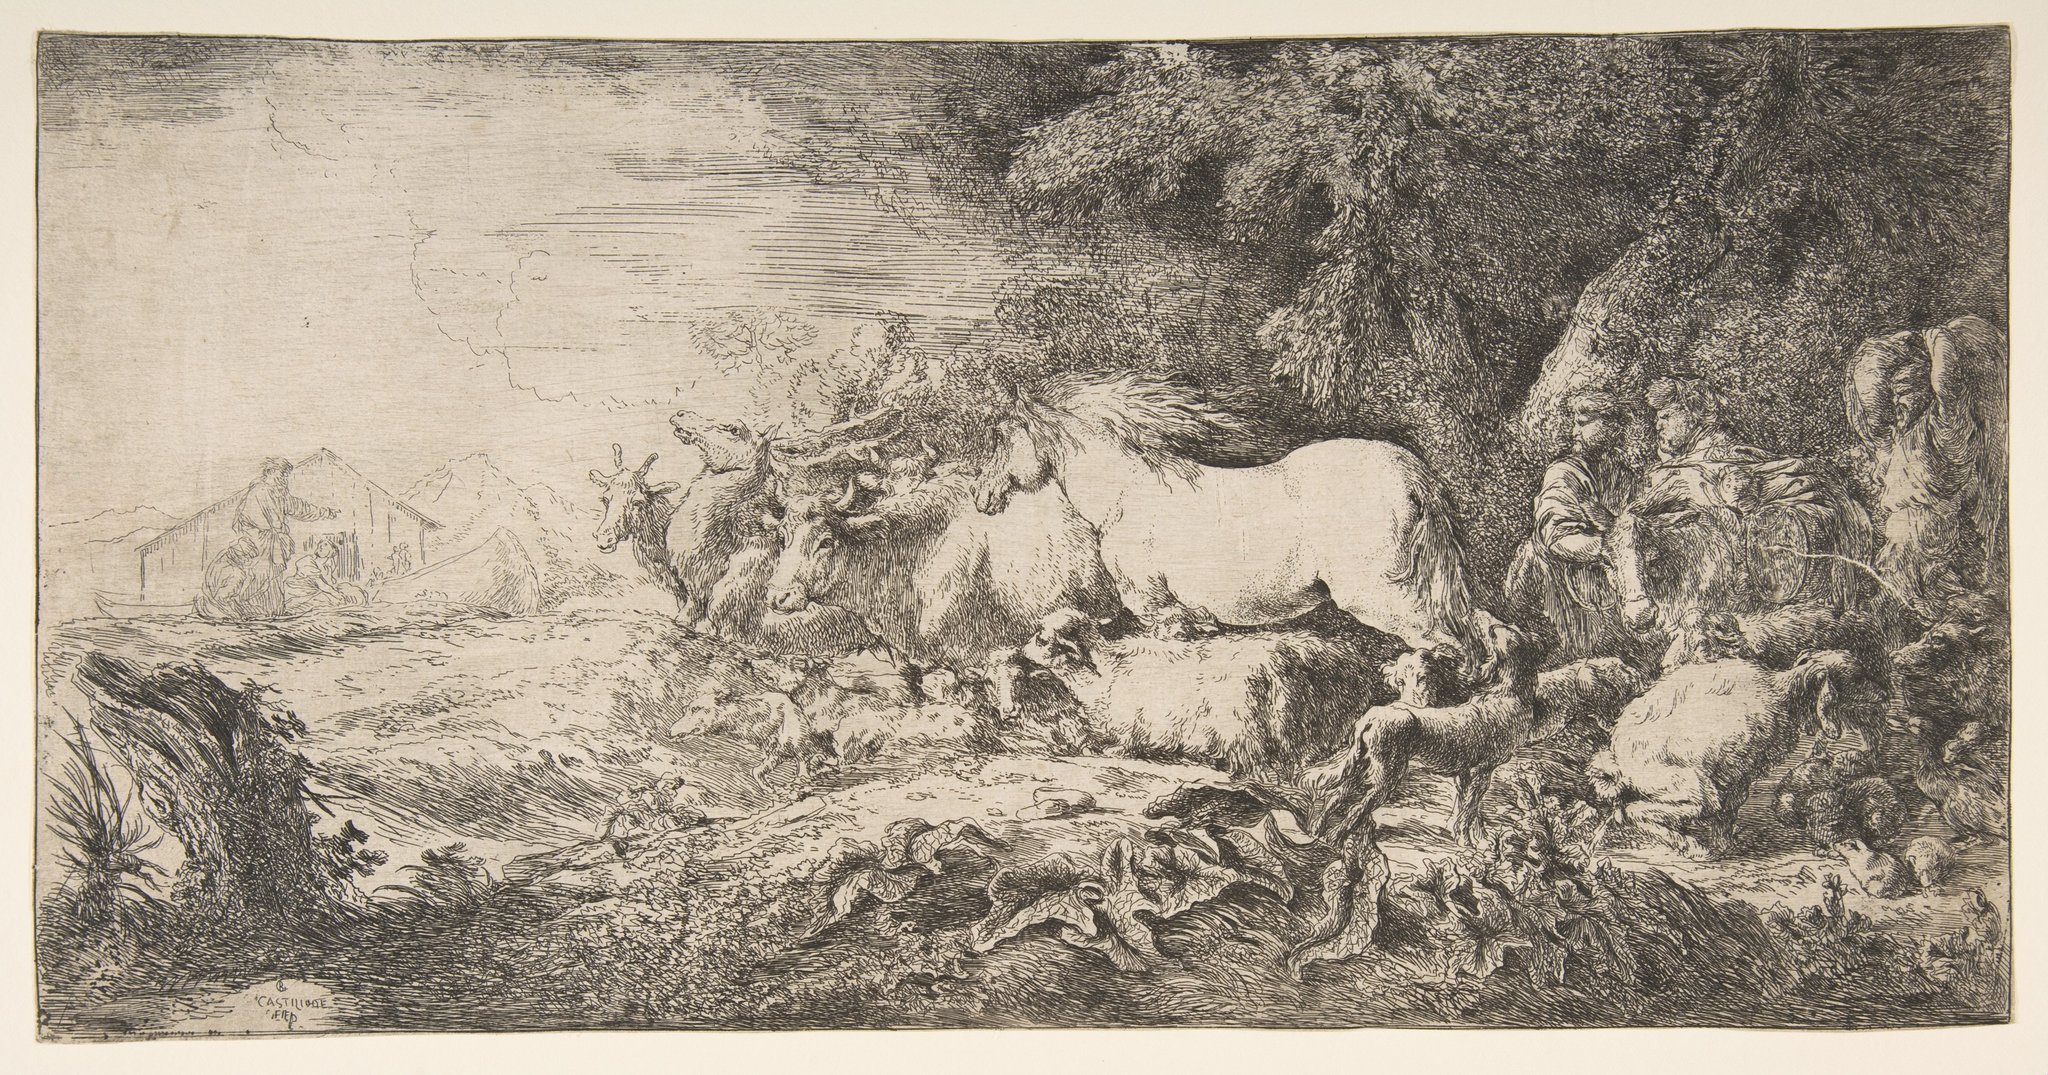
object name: print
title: Noah and the animals entering the ark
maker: giovanni benedetto castiglione (il grechetto)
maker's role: artist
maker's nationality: italian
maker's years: 1609-1664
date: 1650-1655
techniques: etching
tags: men,cows,horses,trees